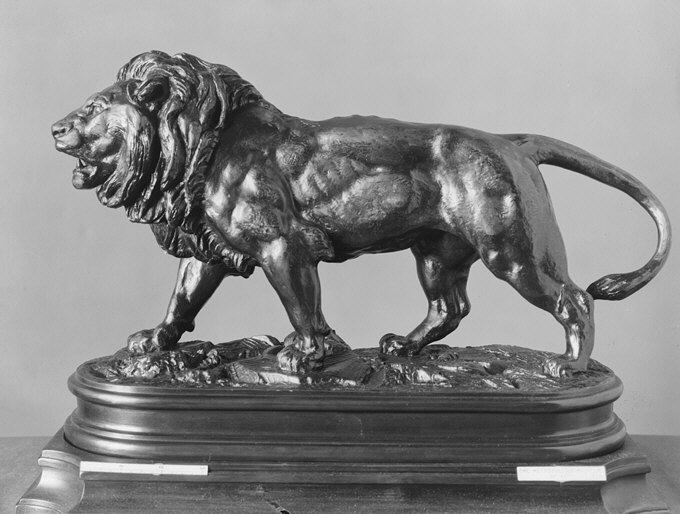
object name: statuette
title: Walking Lion (Le Lion qui Marche)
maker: antoine-louis barye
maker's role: artist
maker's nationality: french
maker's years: 1795-1875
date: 1800-1899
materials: bronze, wood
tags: lions